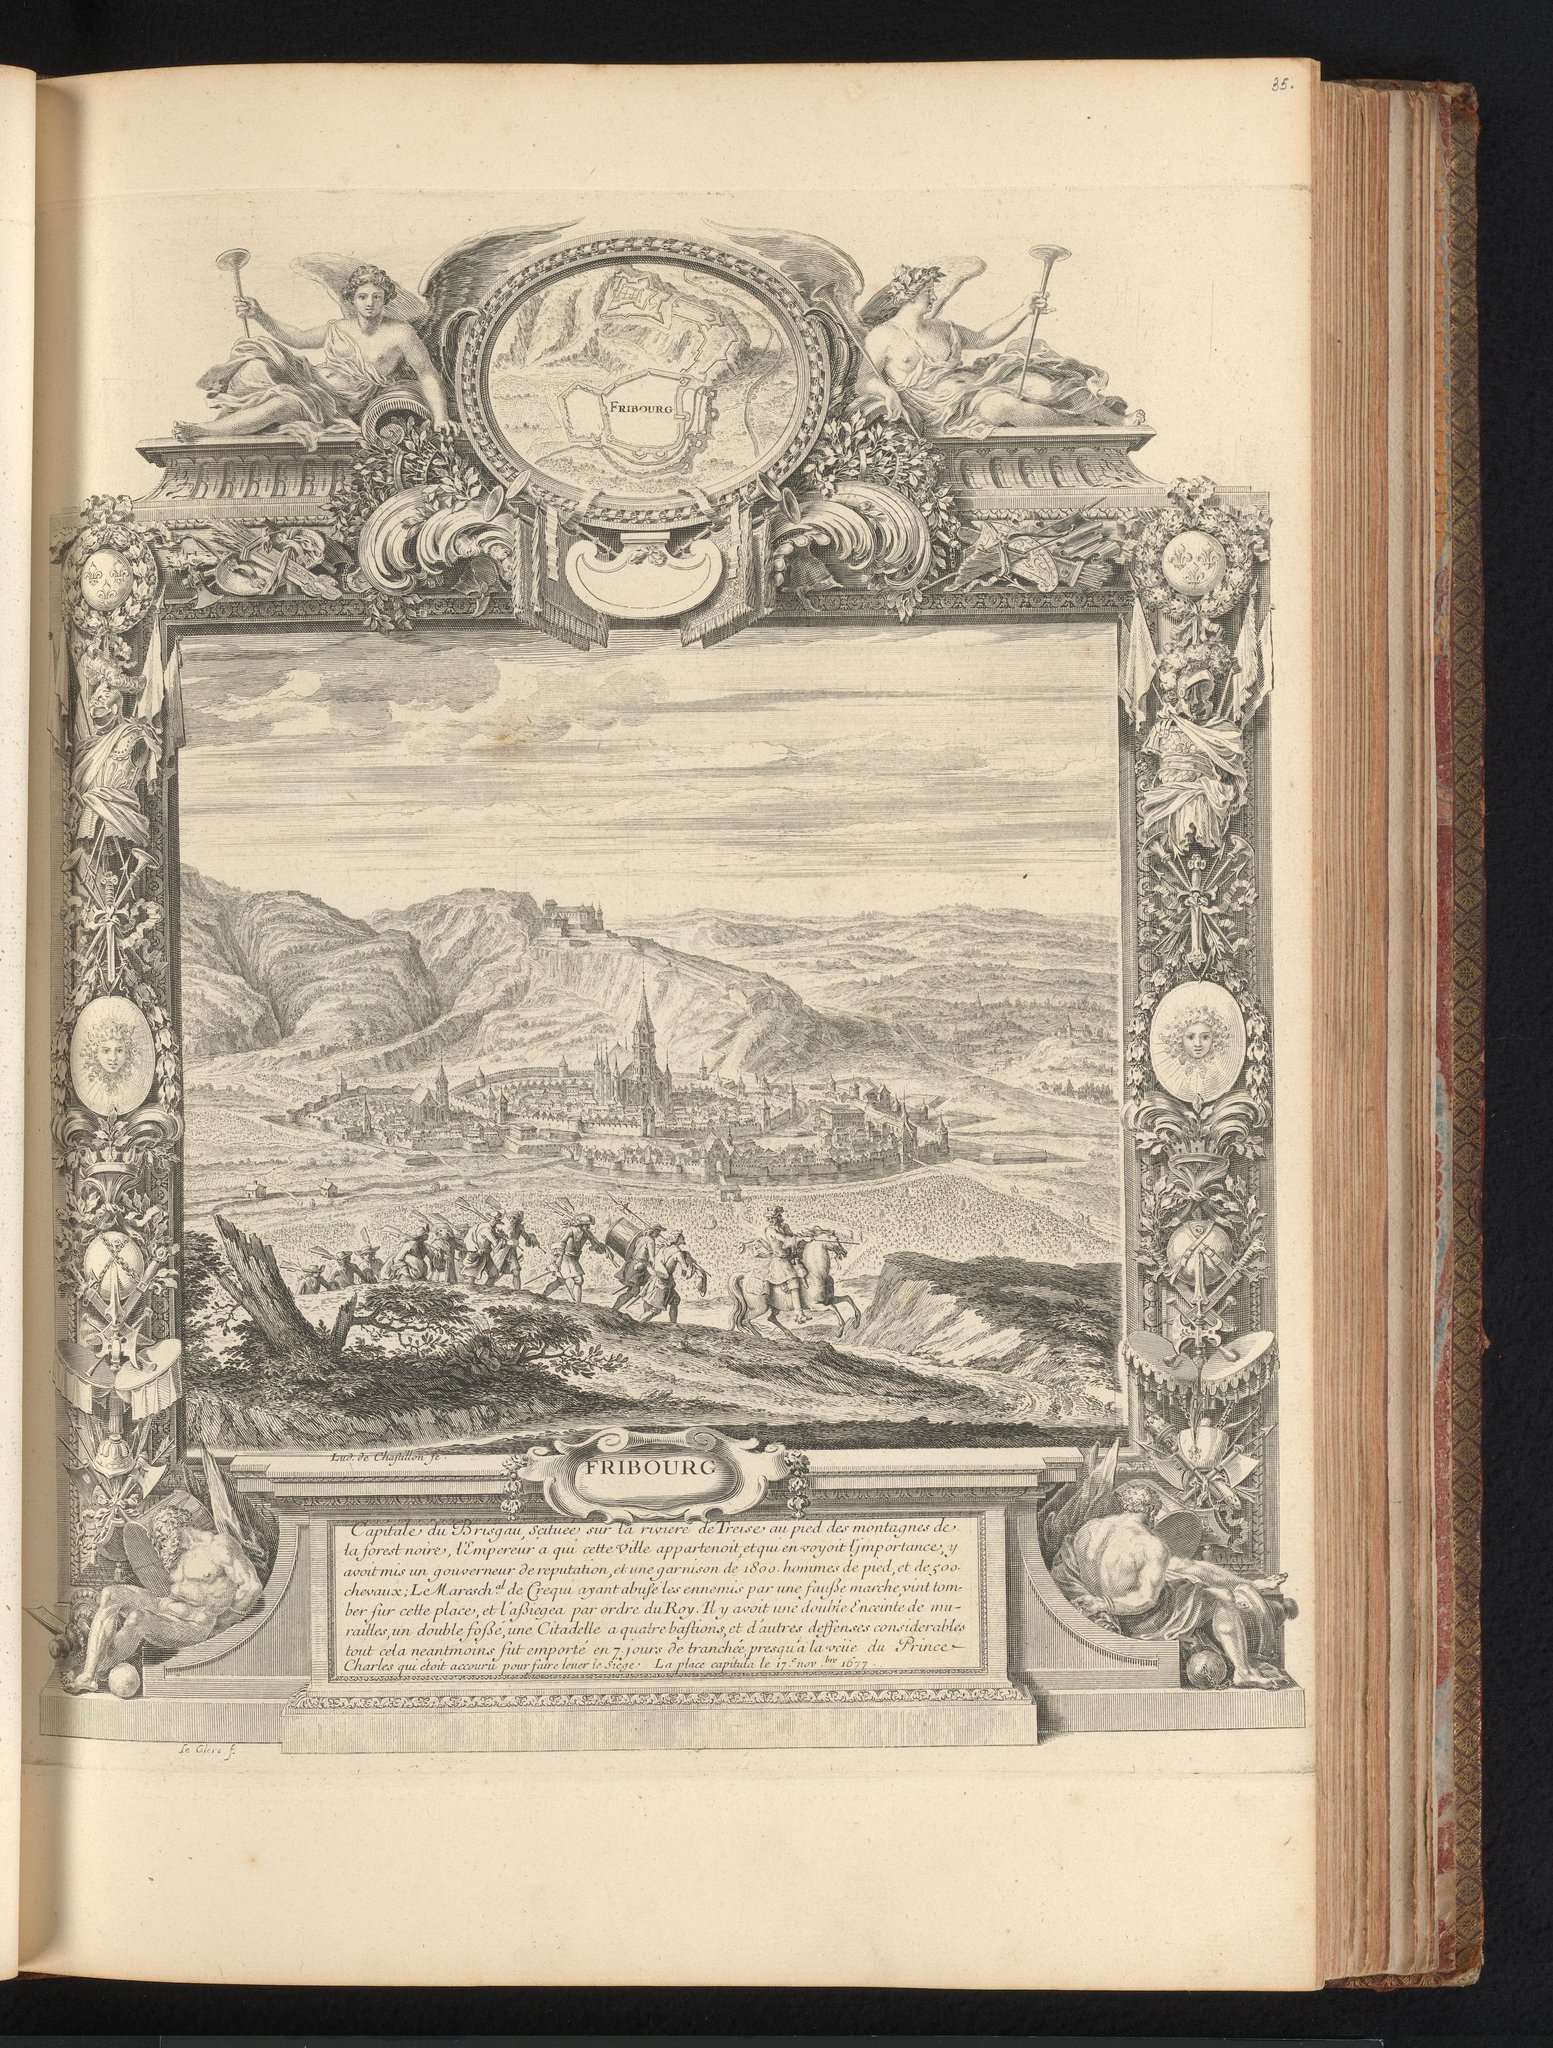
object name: album leaf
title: Fribourg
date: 1686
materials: paper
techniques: engraving, etching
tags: siege, position war, battle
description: Maakt deel uit van een serie bestaande uit 28 prenten met oorlogstaferelen in ornamentele cartouches. De prenten zijn gedrukt van twee afzonderlijke platen bestaande uit de voorstelling en de cartouche.